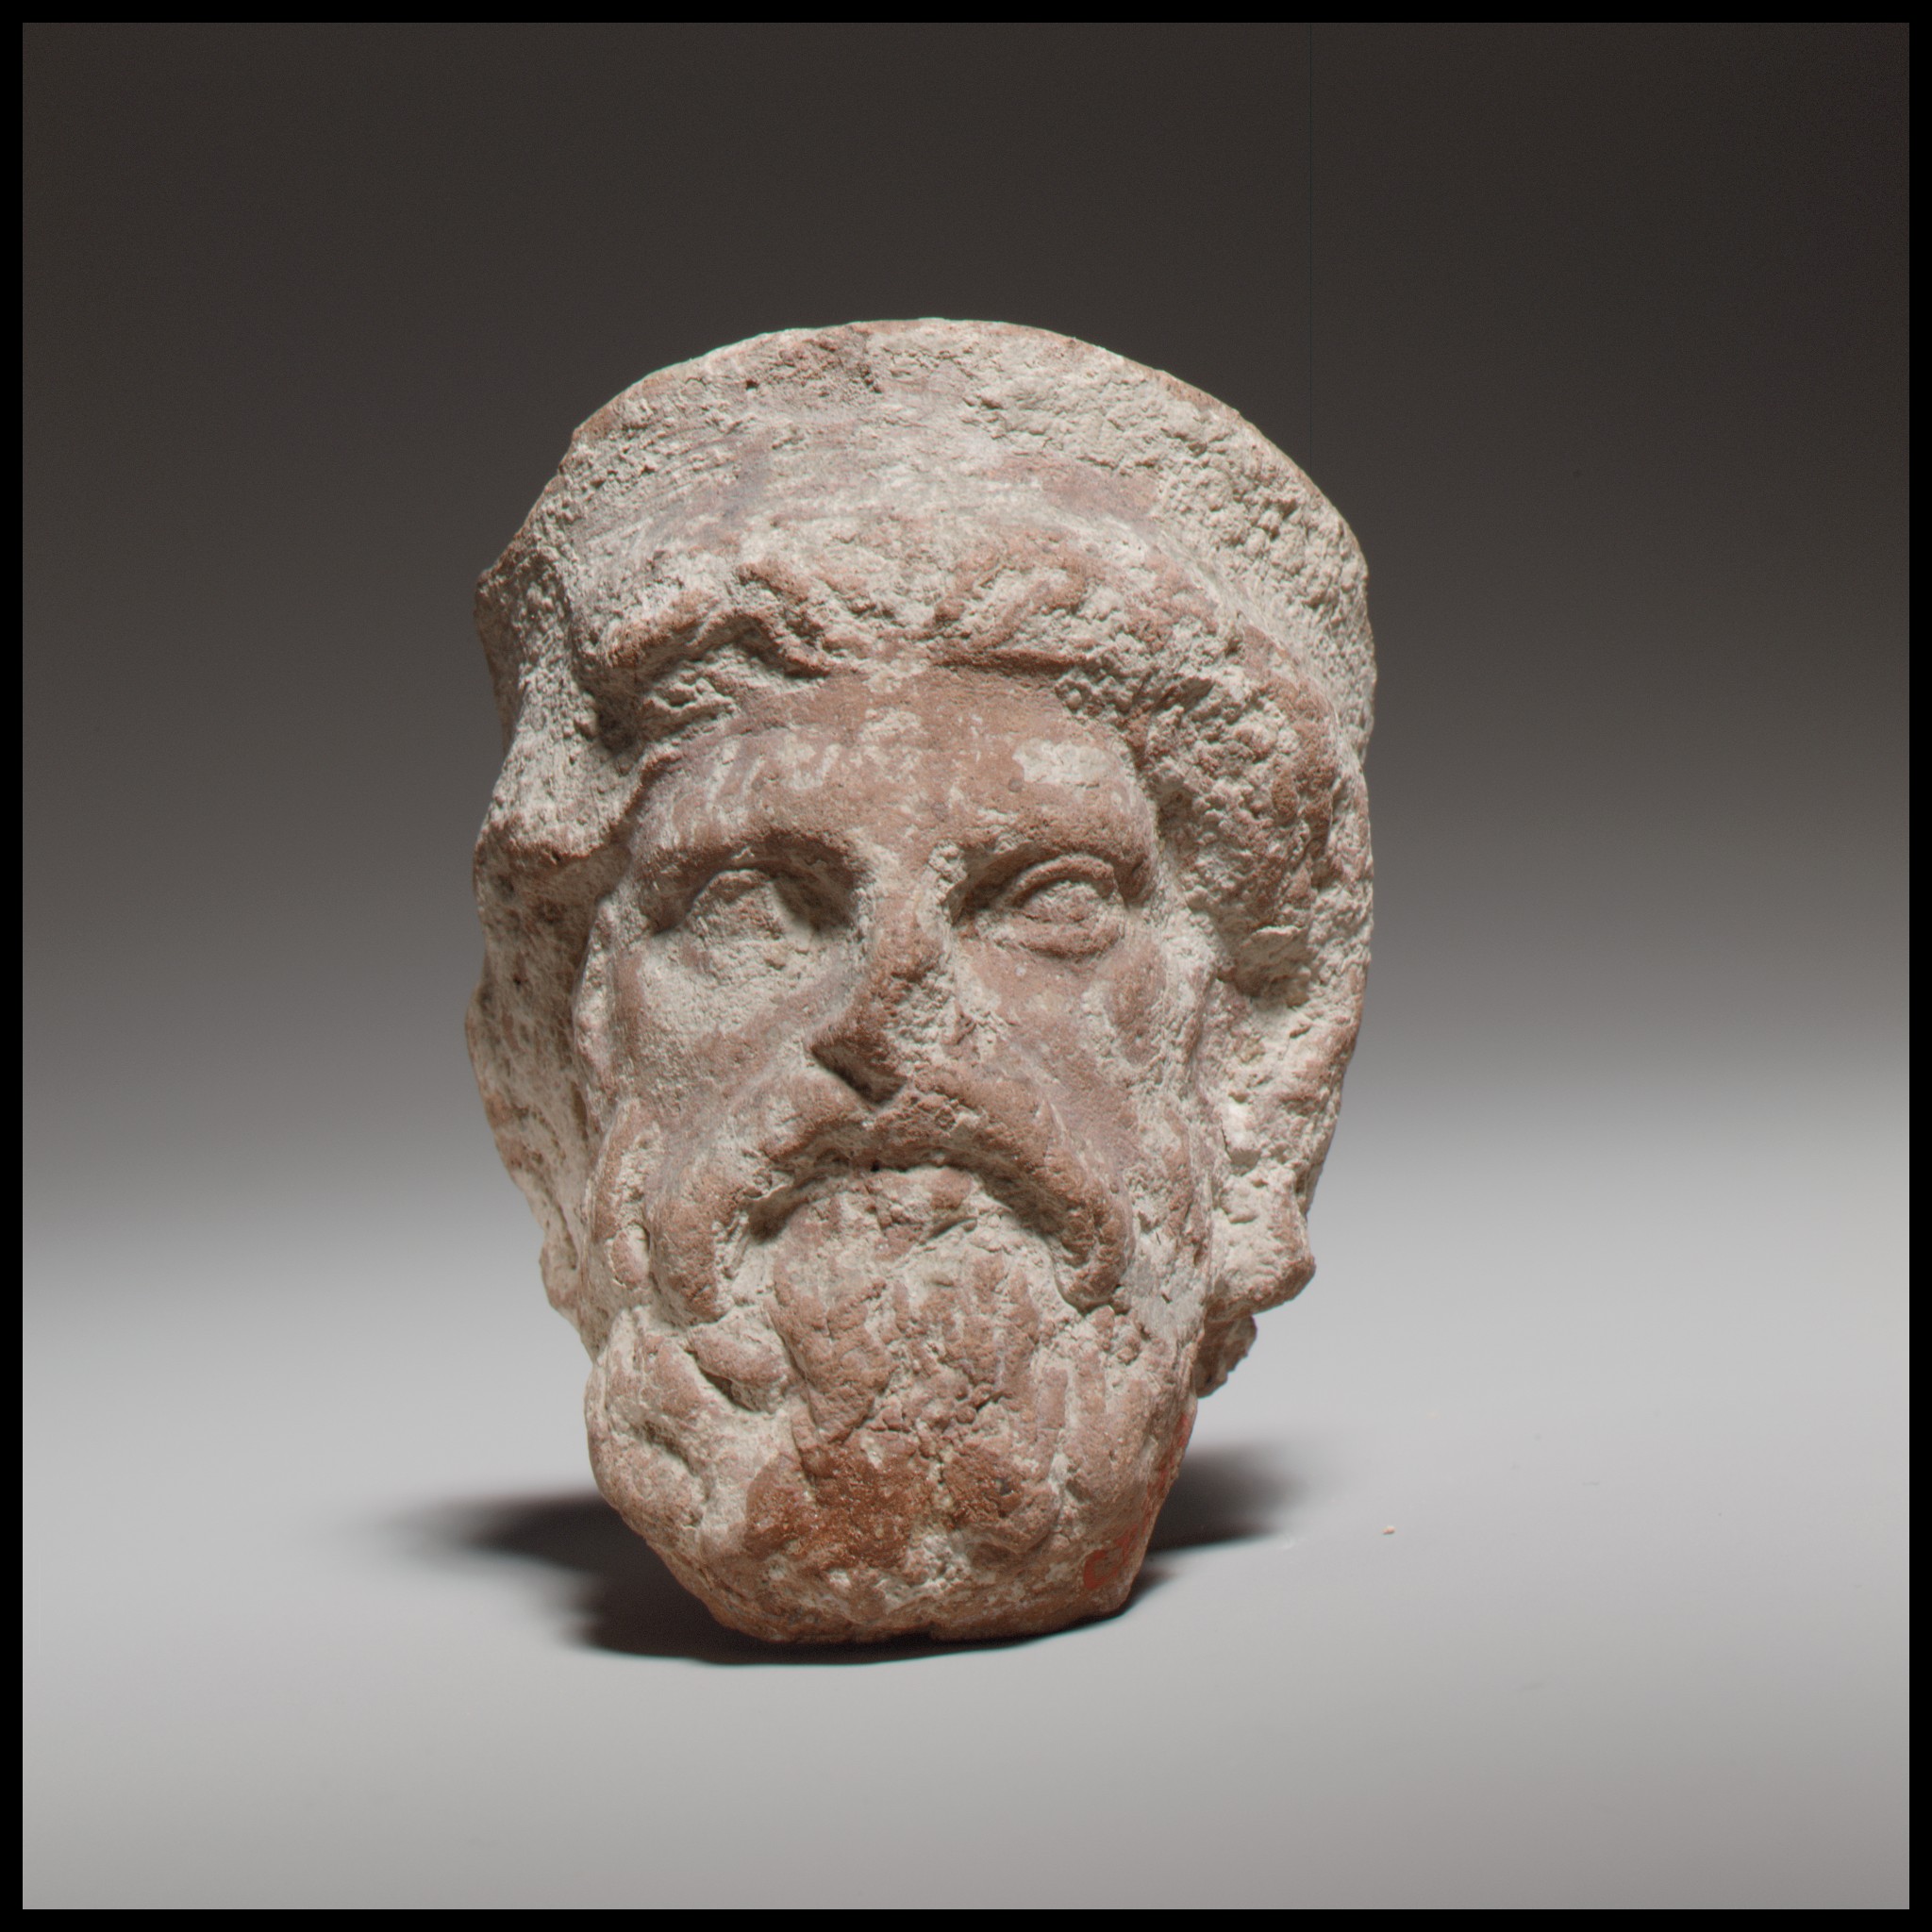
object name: head of a deity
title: Terracotta head of a bearded god, perhaps Zeus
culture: cypriot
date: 200-101 BCE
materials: terracotta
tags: heads,zeus